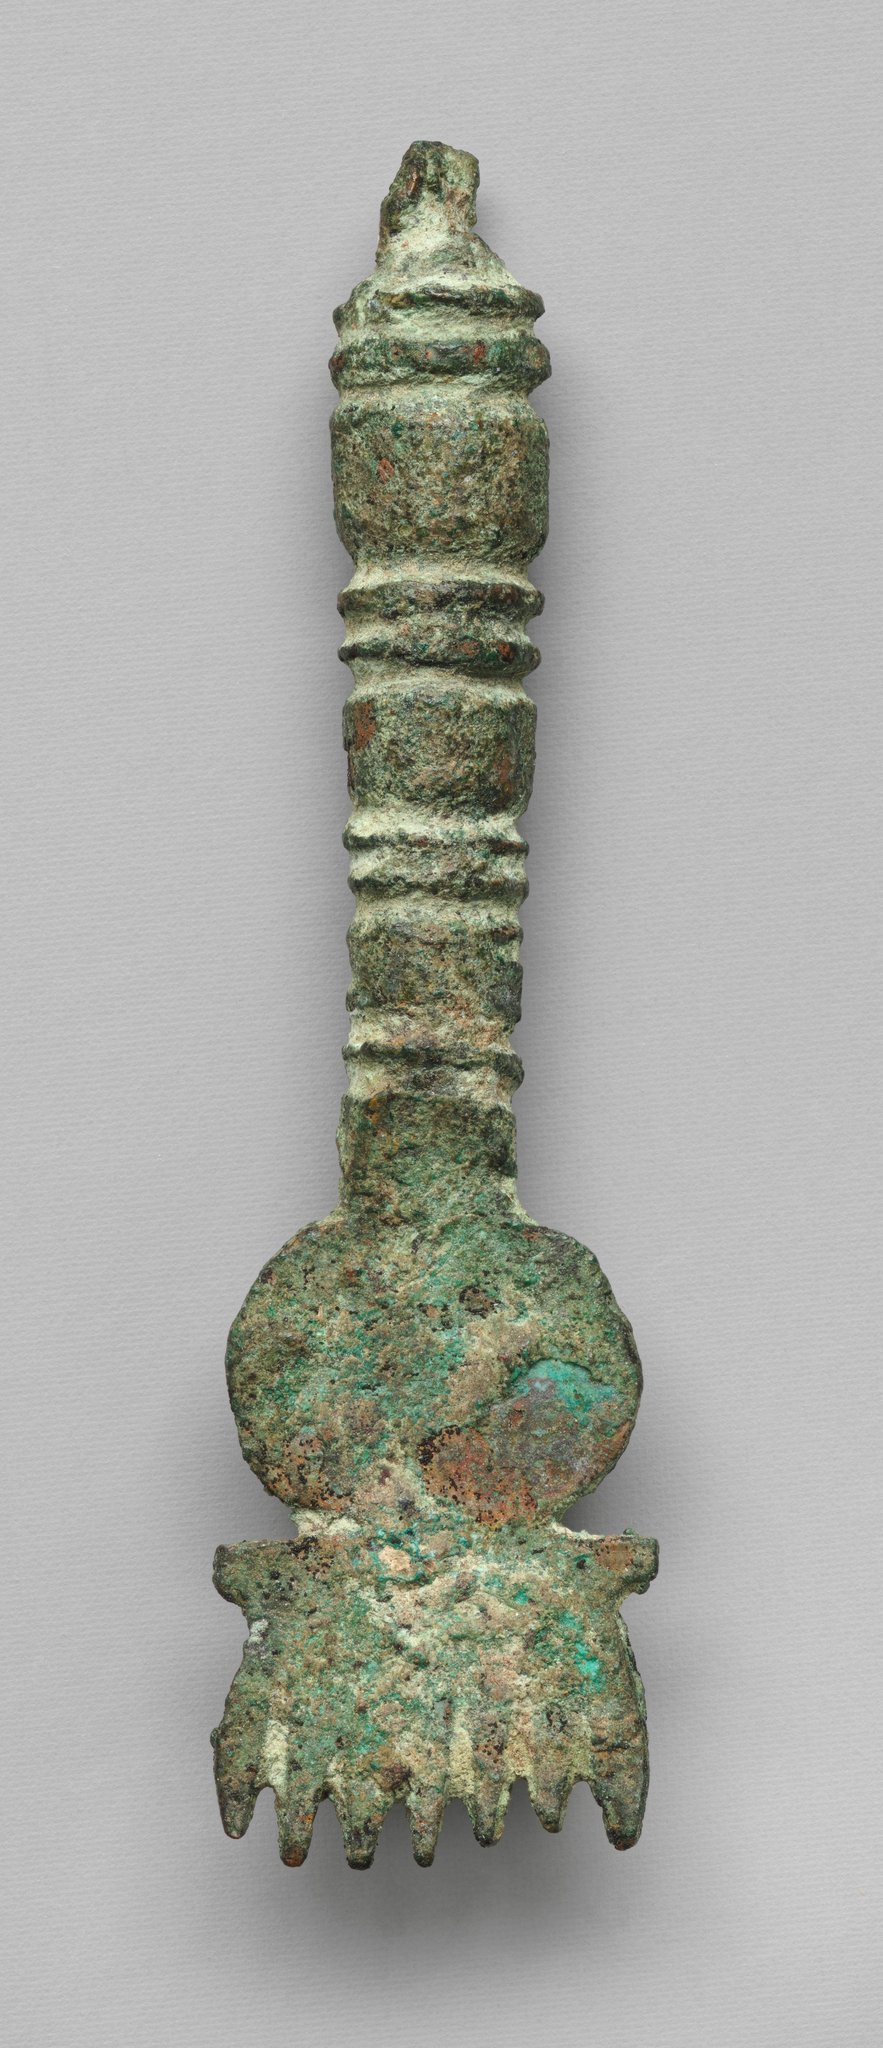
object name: tool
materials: copper alloy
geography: egypt